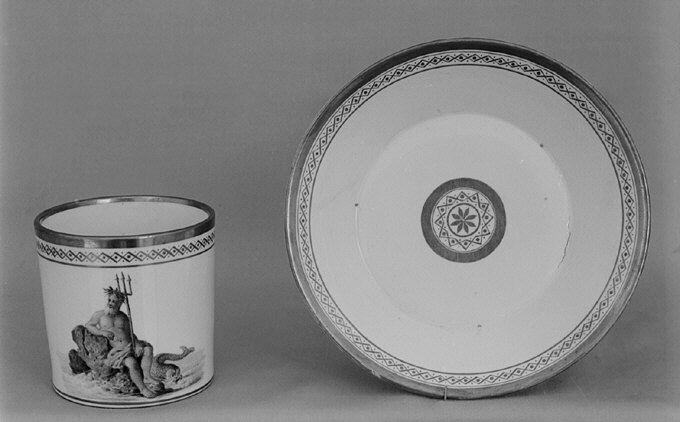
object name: saucer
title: Saucer (part of a coffee service)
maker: nymphenburg porcelain manufactory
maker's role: manufactory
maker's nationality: german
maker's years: 1747-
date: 1801-1833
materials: hard paste porcelain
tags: men